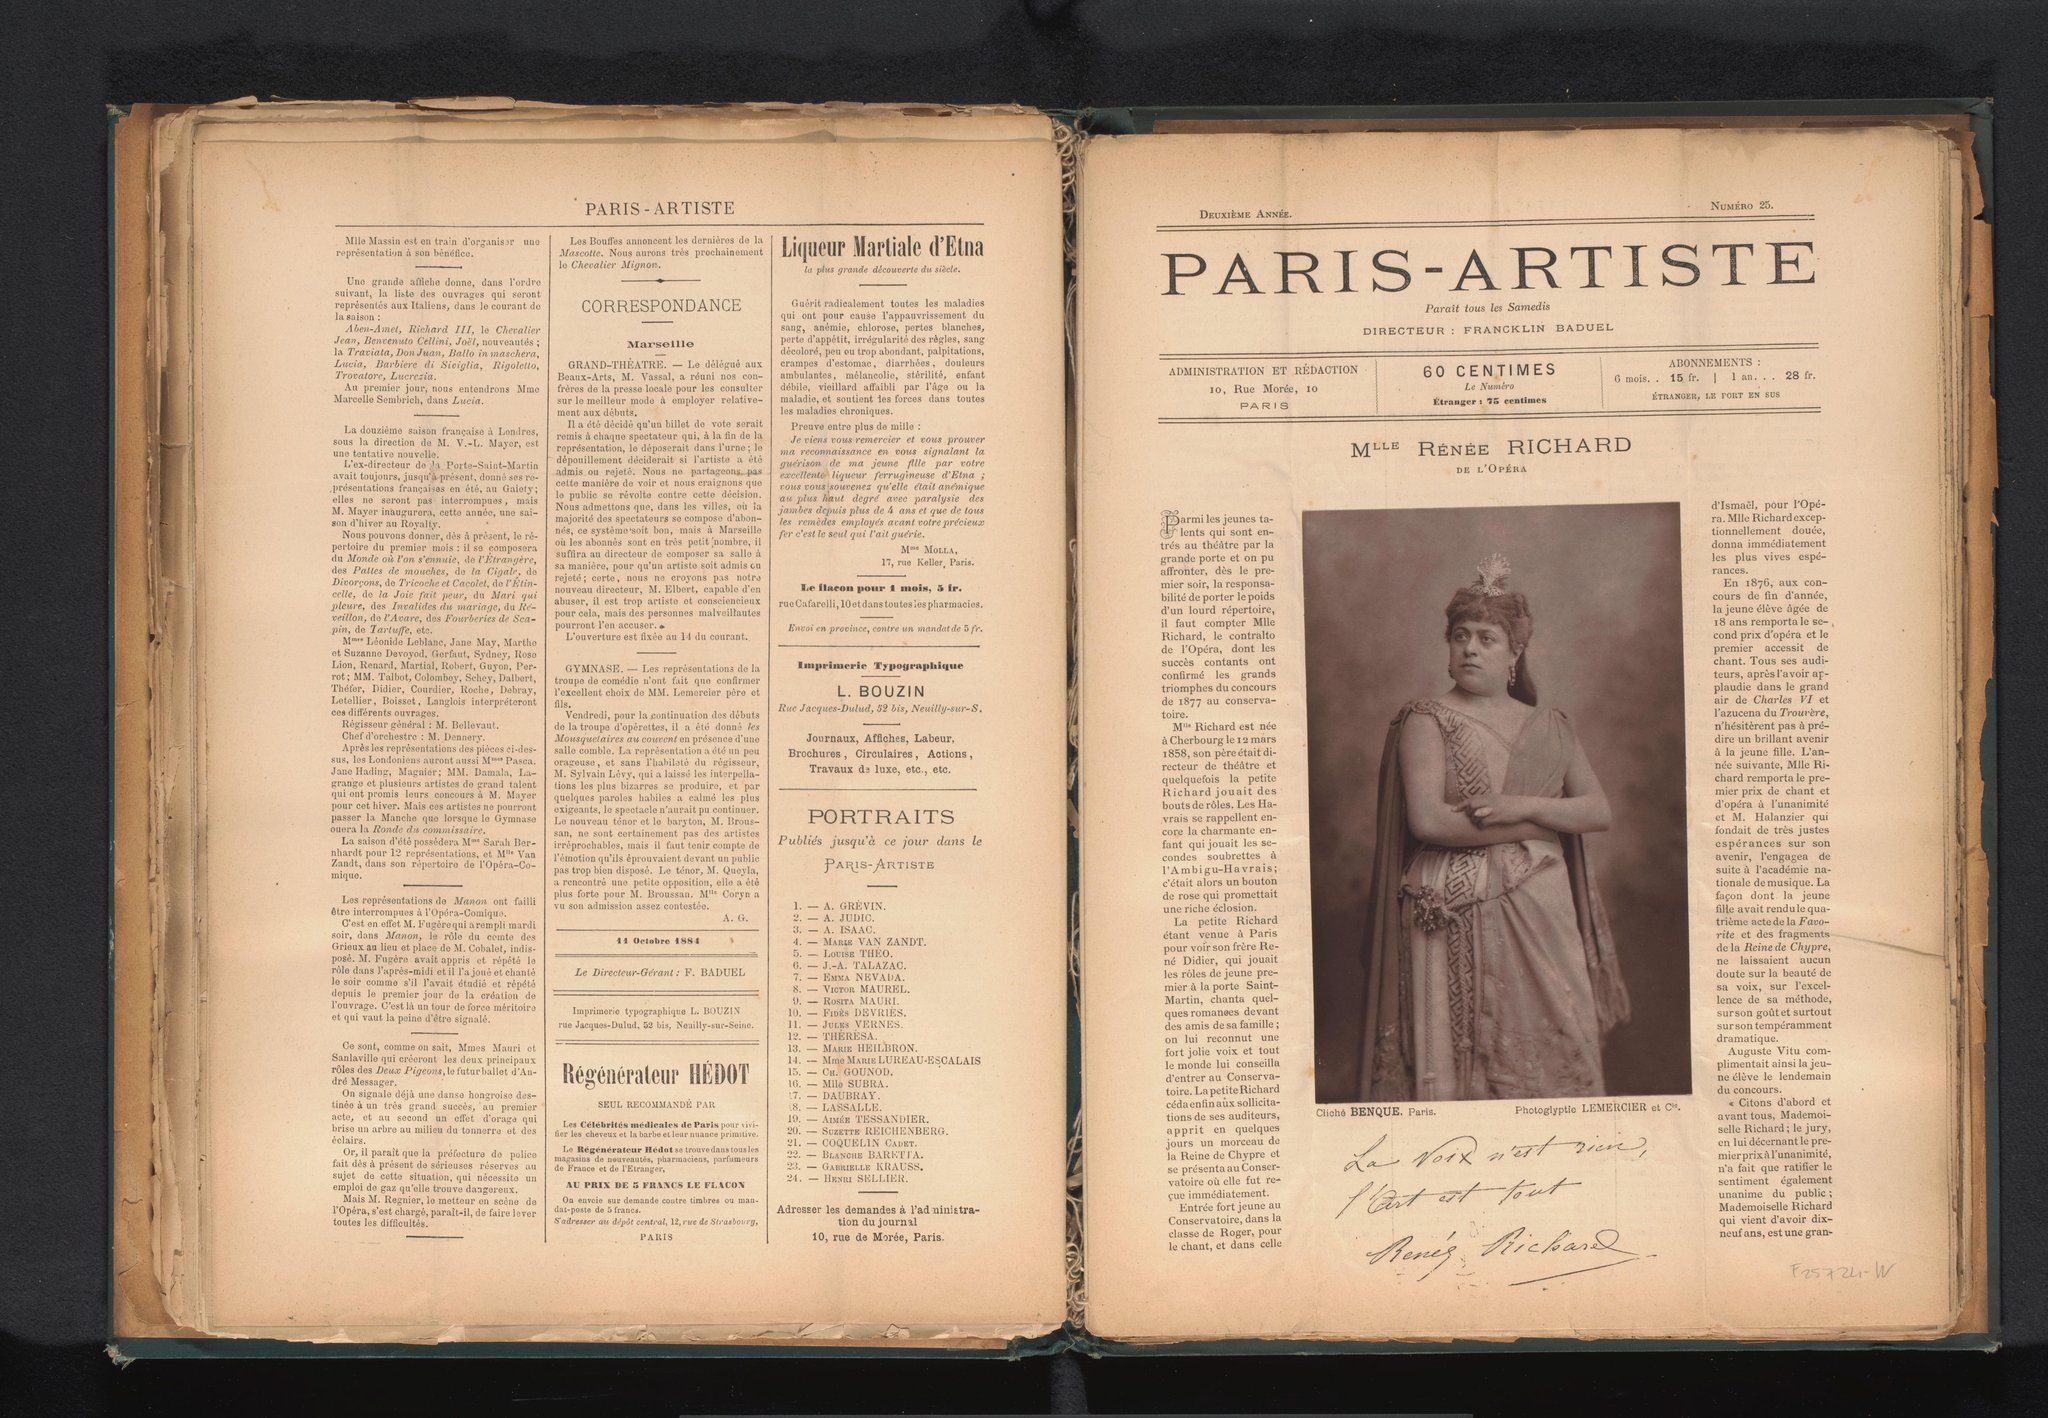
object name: photomechanical print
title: Portret van Renée Richard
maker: wilhelm benque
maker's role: fotograaf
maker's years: 1843-1903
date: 1875-1884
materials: paper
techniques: woodburytype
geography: paris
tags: historical persons - bb - woman, opera-singer (female)